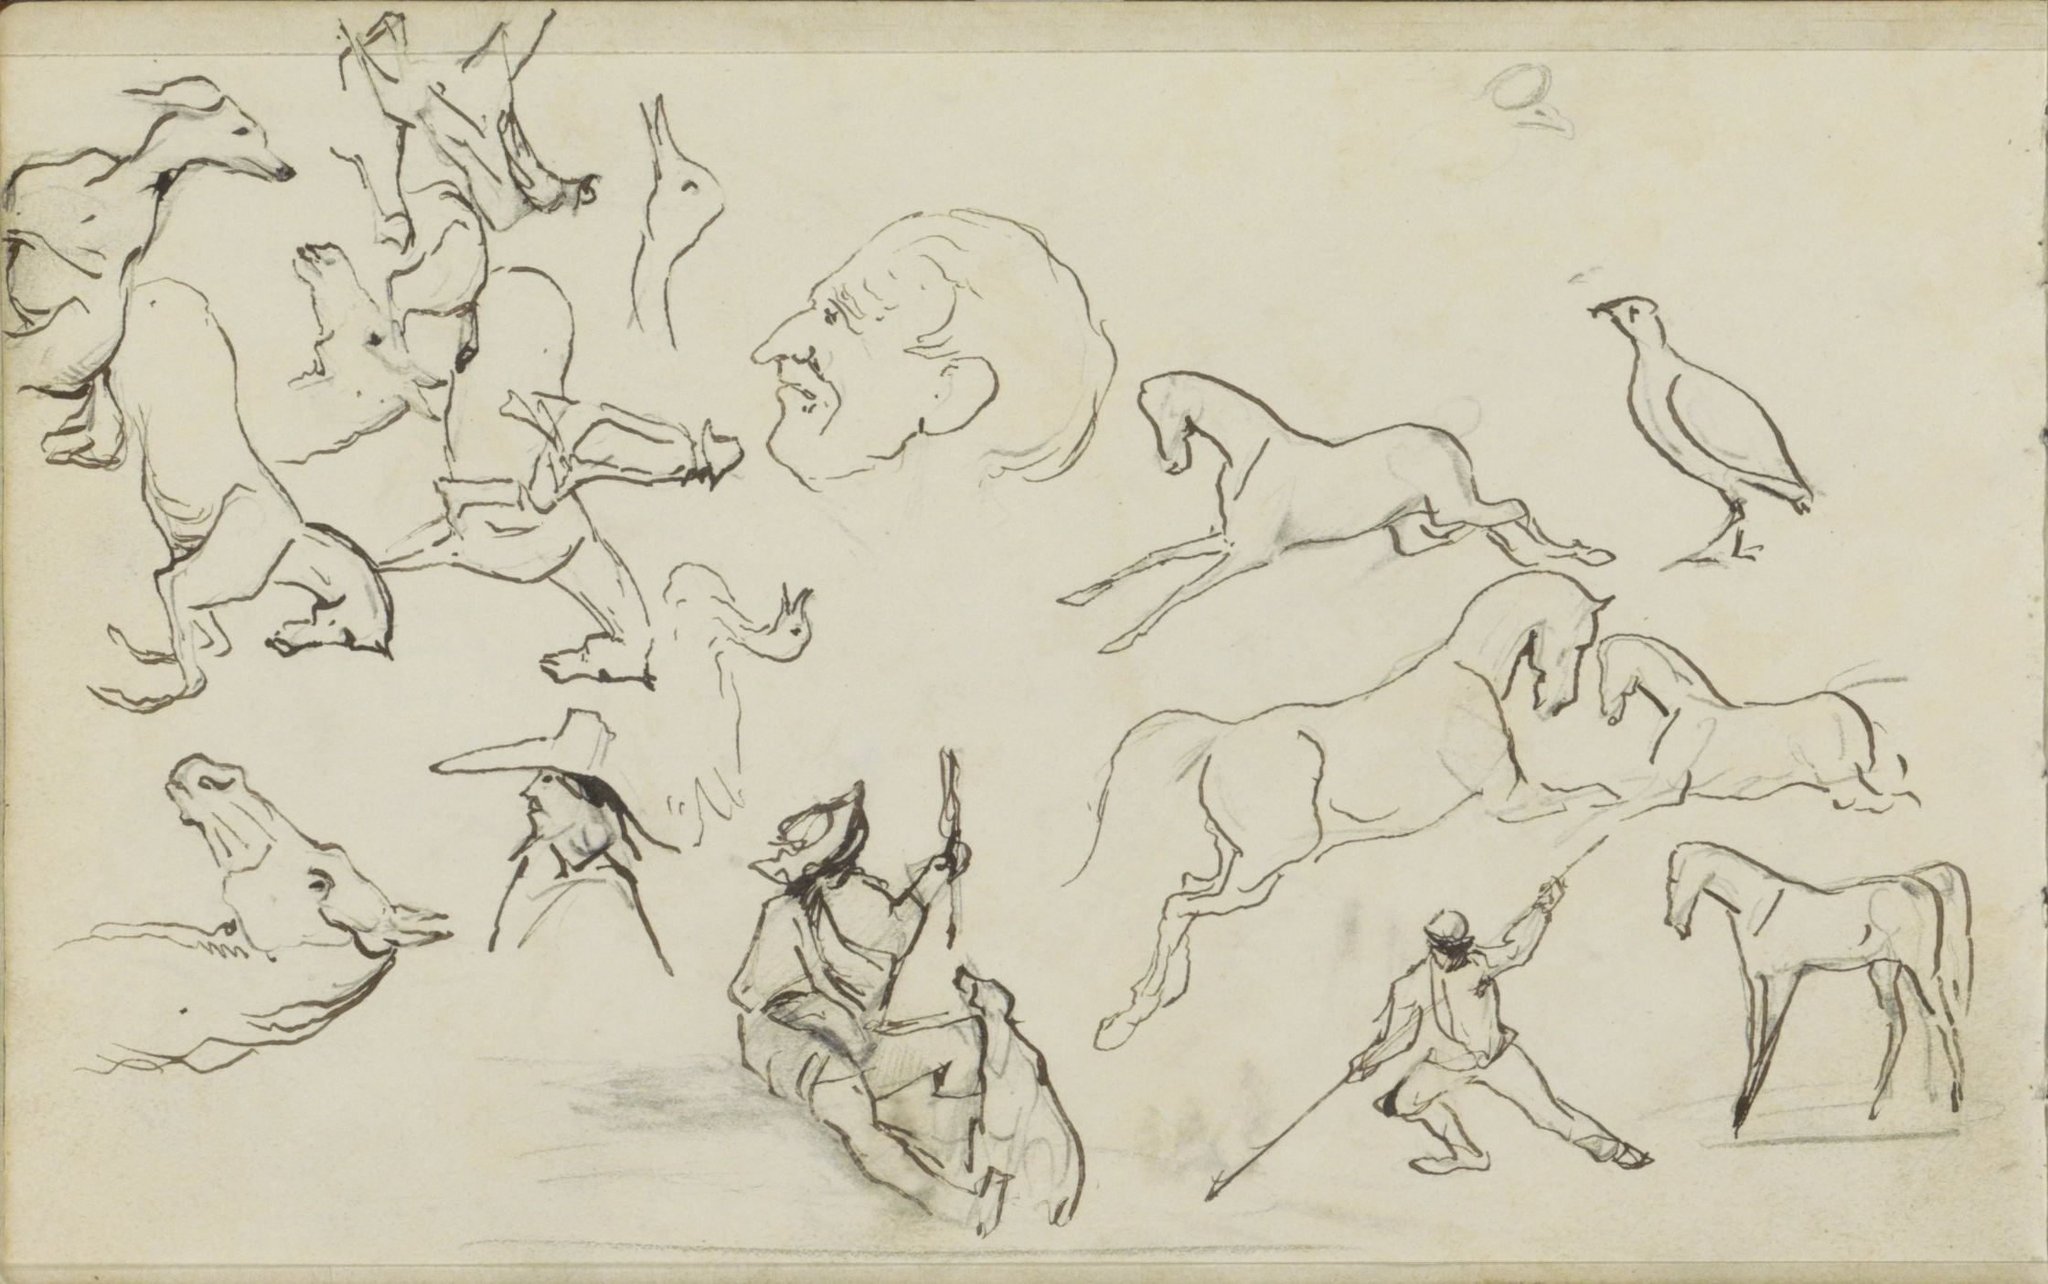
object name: sketchbook leaf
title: Studieblad, onder andere met paarden en ruiters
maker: johannes tavenraat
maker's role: draughtsman, painter, print maker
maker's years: 1809-1881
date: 1839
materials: paper, pencil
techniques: pen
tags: riding a horse, ass, or mule; rider, horseman, head (human), adult man, ducks (domestic waterbirds), horse, dog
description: Tevens studies van koppen, mansfiguren, eenden en honden. Blad 8 verso uit een schetsboek met 37 bladen.